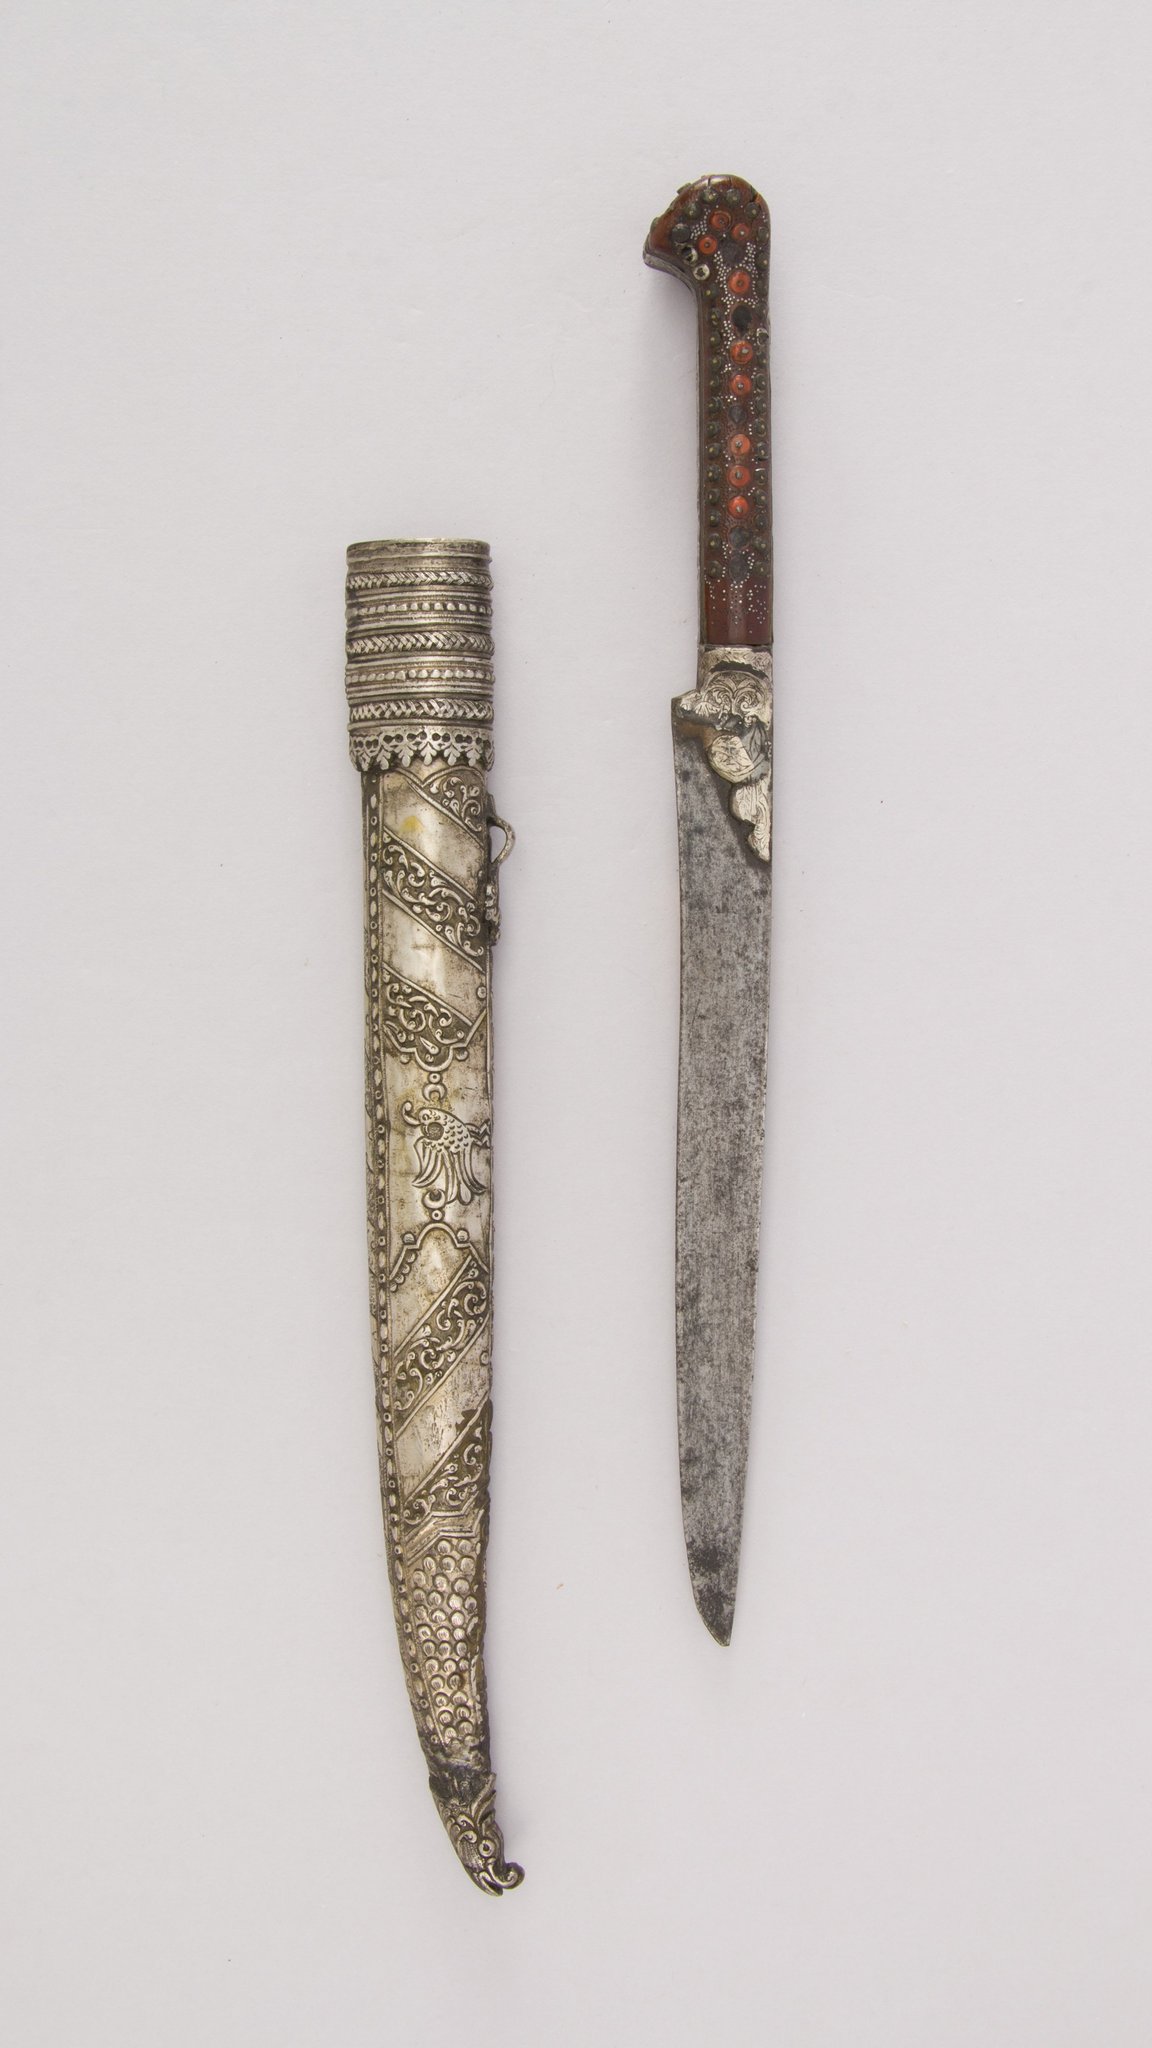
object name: knife with sheath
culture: turkish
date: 1801-1900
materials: brass, coral, silver, steel, wood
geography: turkey